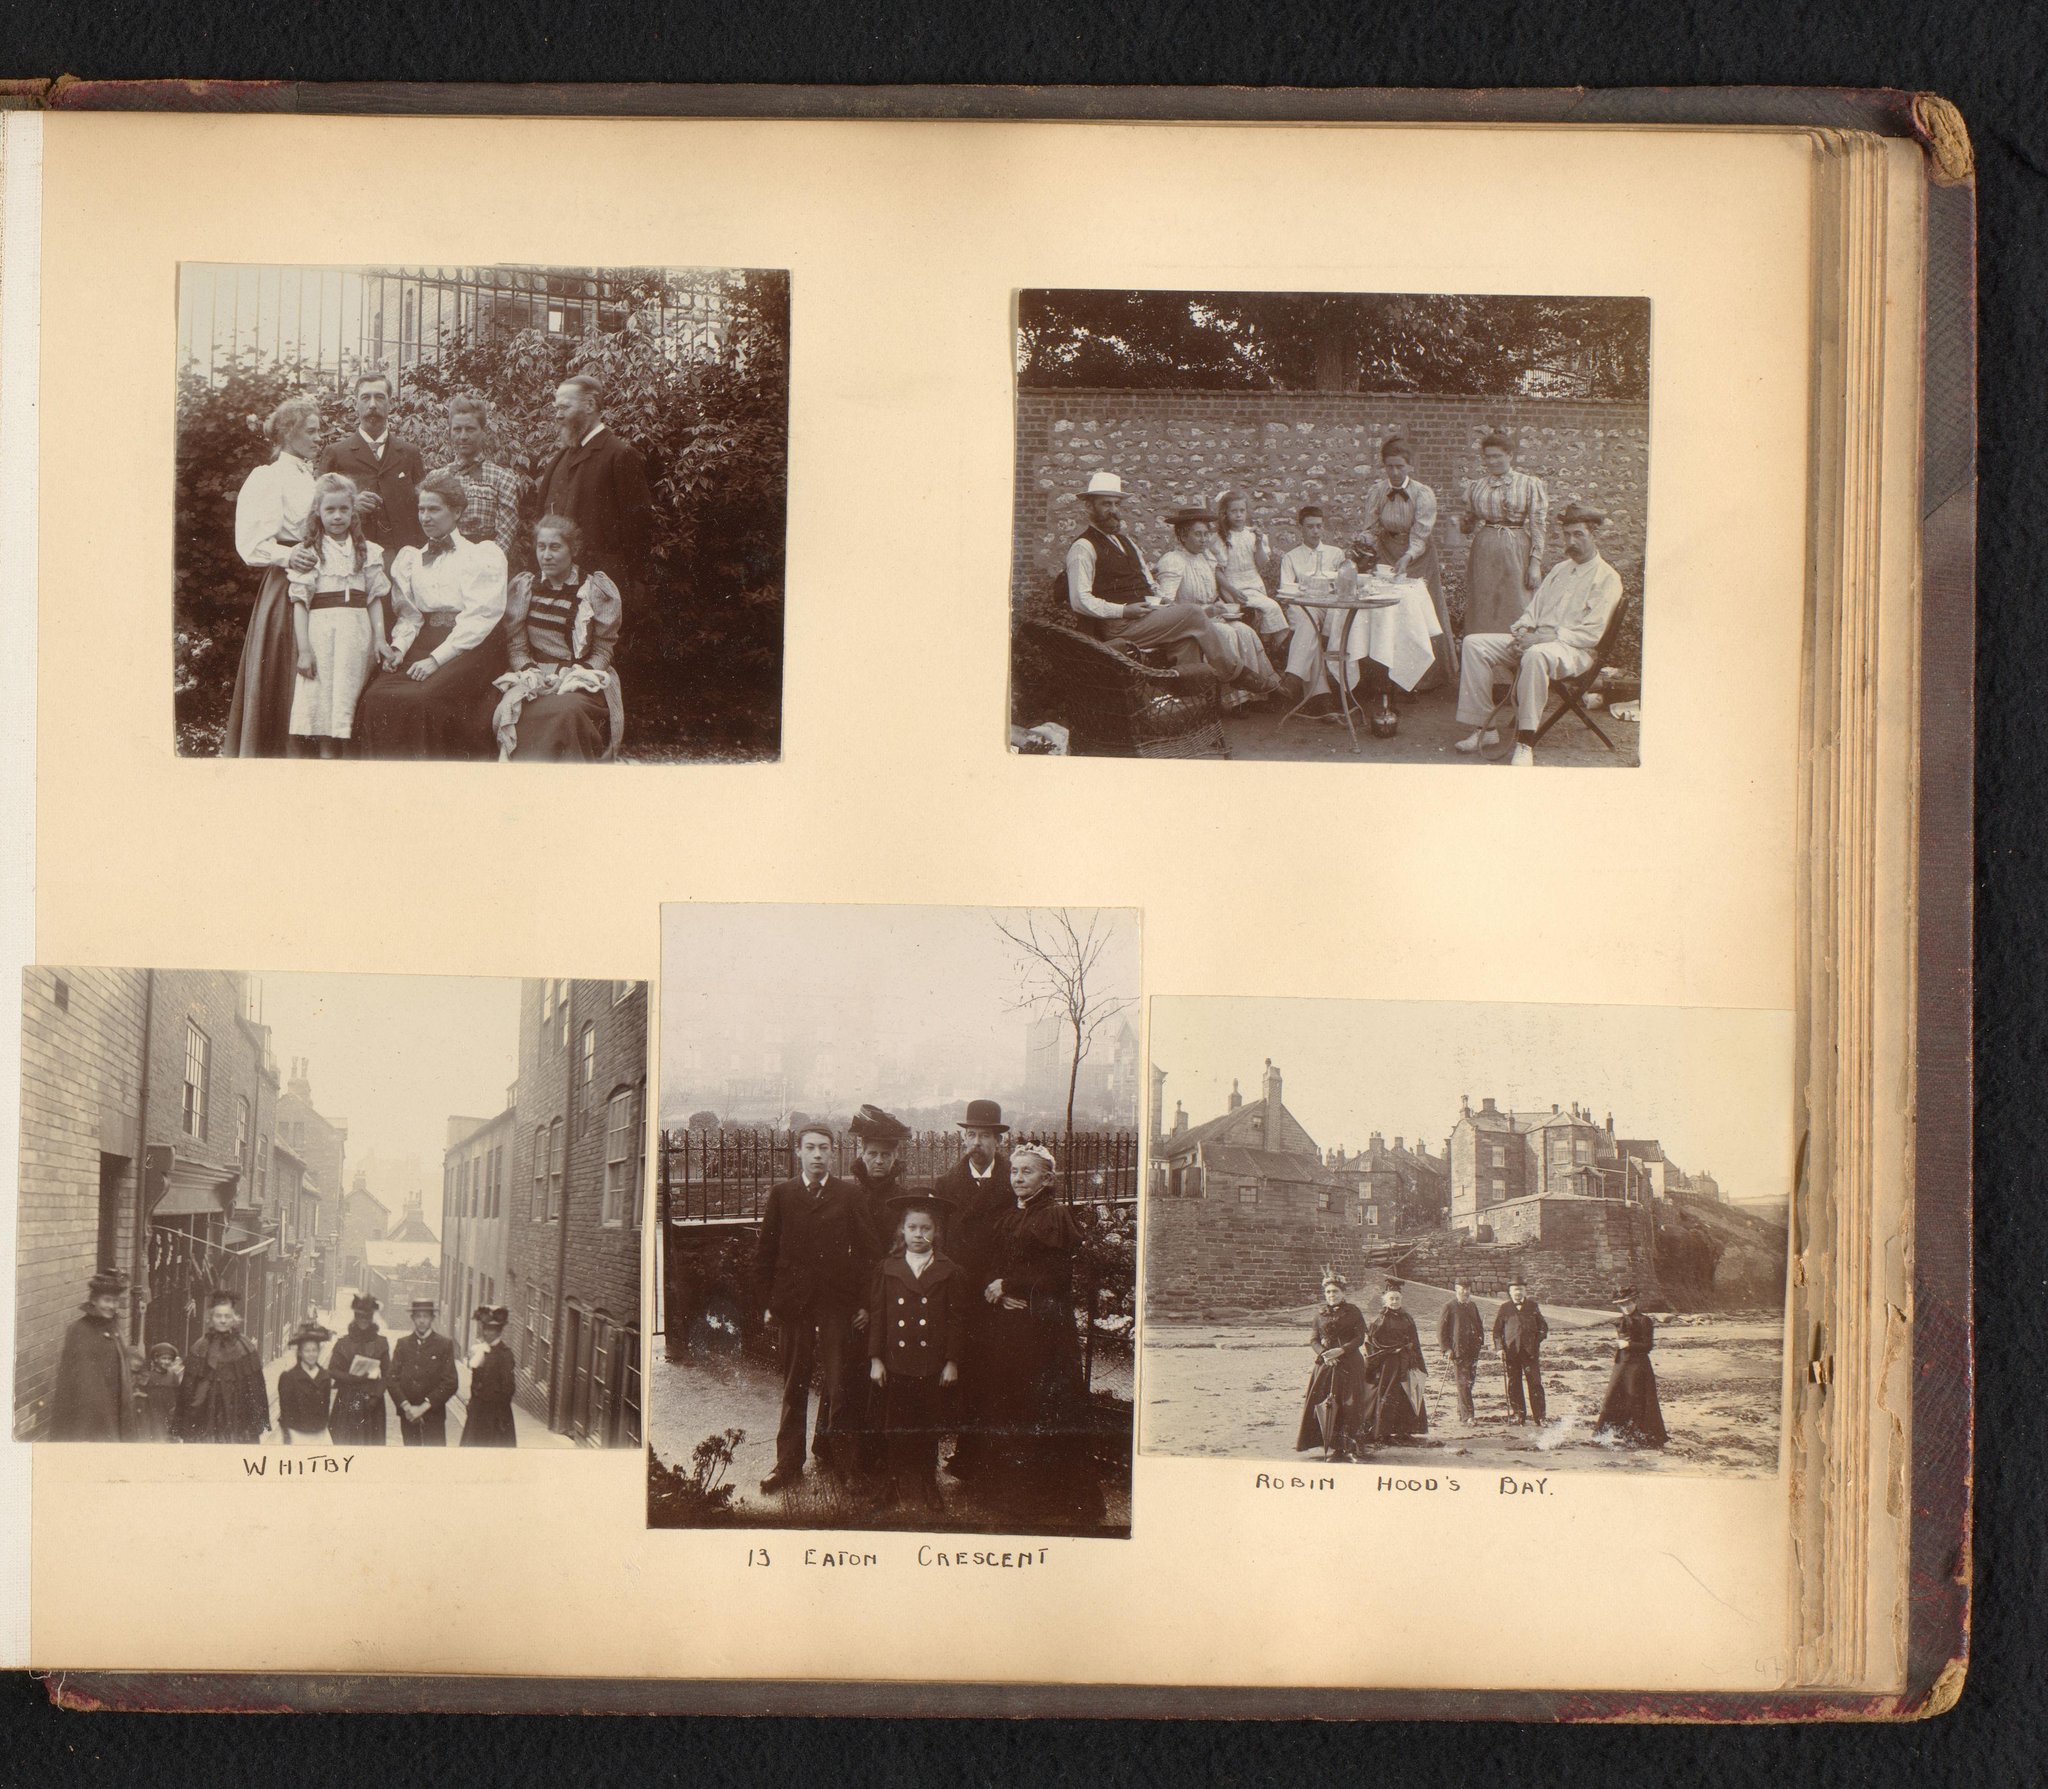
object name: album leaf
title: Familieportretten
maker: Anonymous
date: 1890-1898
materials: photographic support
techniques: collodion silver print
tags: family, descendance, street, beach, anonymous historical persons portrayed in a group, in a group-portrait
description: Groepsportretten in onder meer Whitby, Robin Hood's Bay en bij13 Easton Crescent. Deze pagina maakt deel uit van een album.